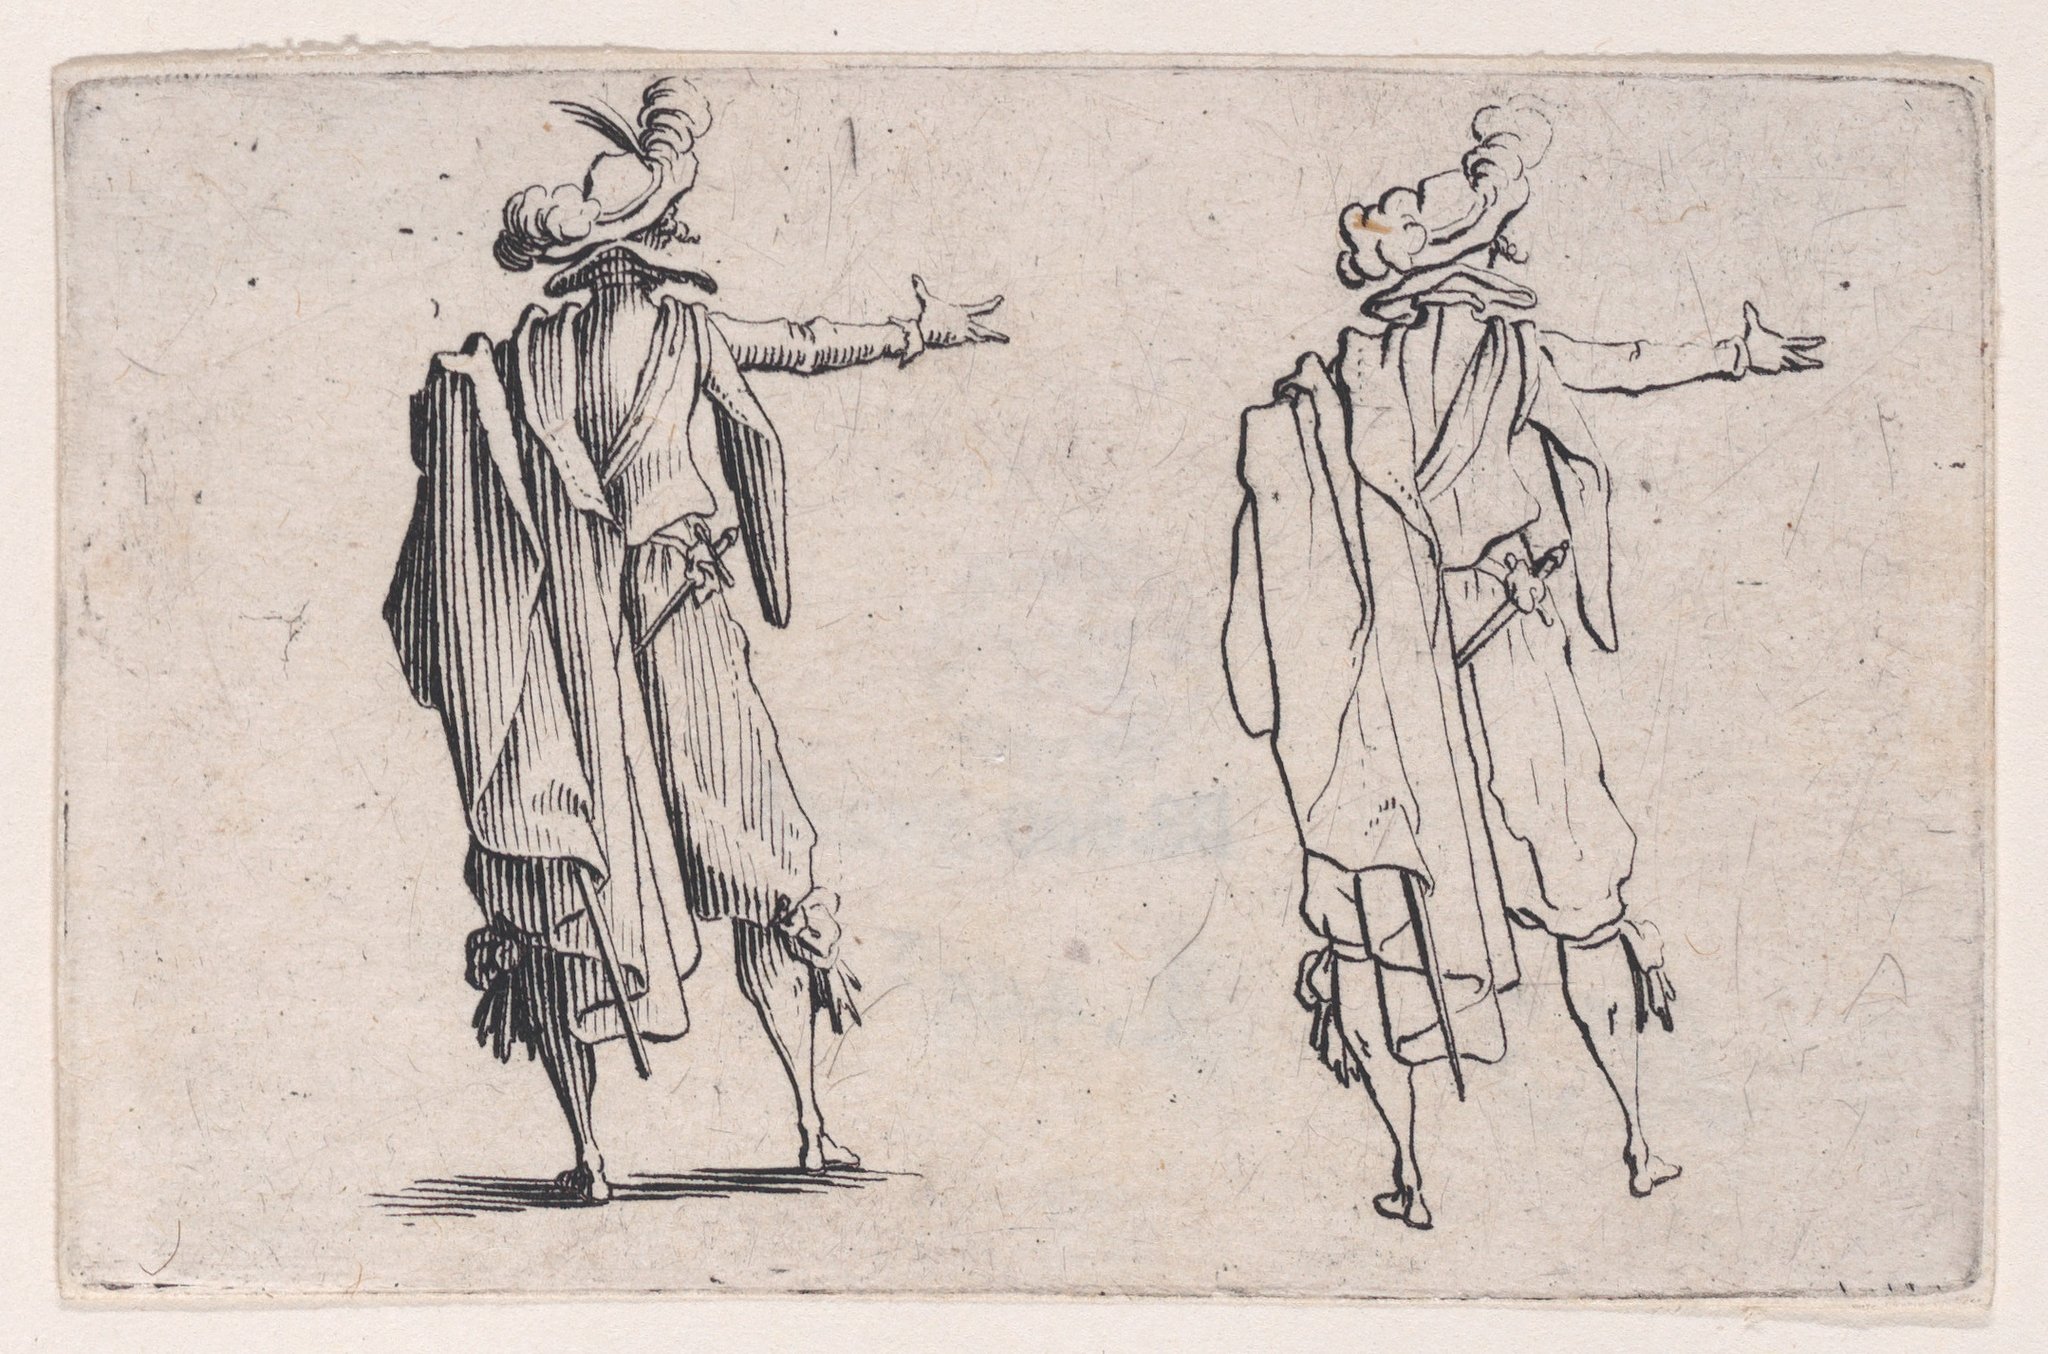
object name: print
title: L'Homme Vu de Dos, La Main Droite Tendue (Man Viewed from Behind, Right Hand Extended), from Les Caprices Series B, The Nancy Set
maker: jacques callot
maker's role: artist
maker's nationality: french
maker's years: 1592-1635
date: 1617-1620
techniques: etching